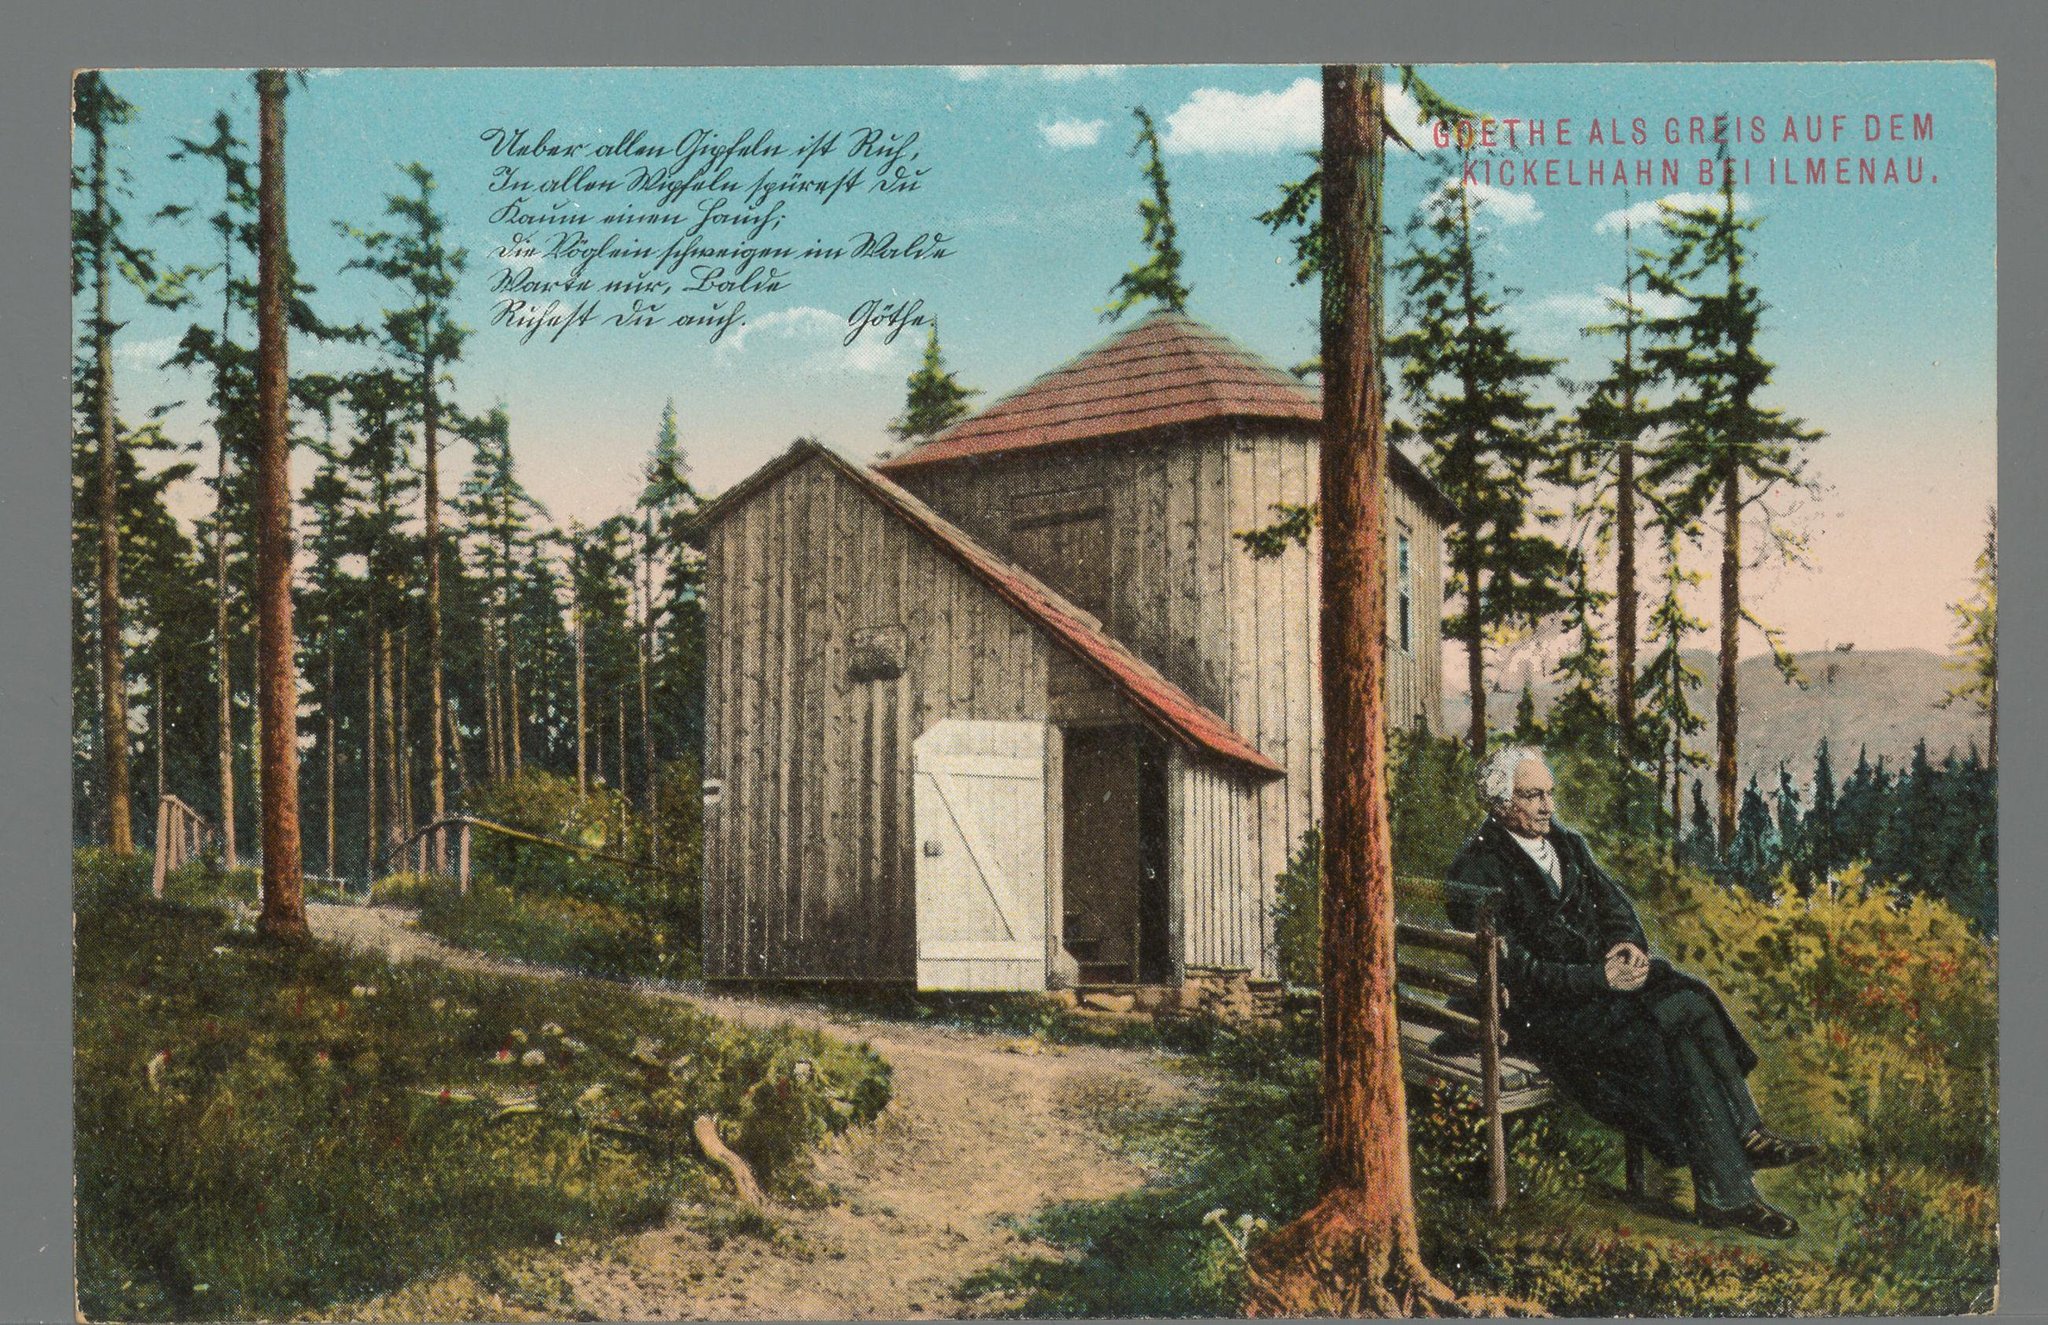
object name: photomechanical print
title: Goethe als Greis auf dem Kickelhahn bei Ilmenau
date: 1905-1930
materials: cardboard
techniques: lithograph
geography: munich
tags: johann wolfgang von goethe, writer, poet, author